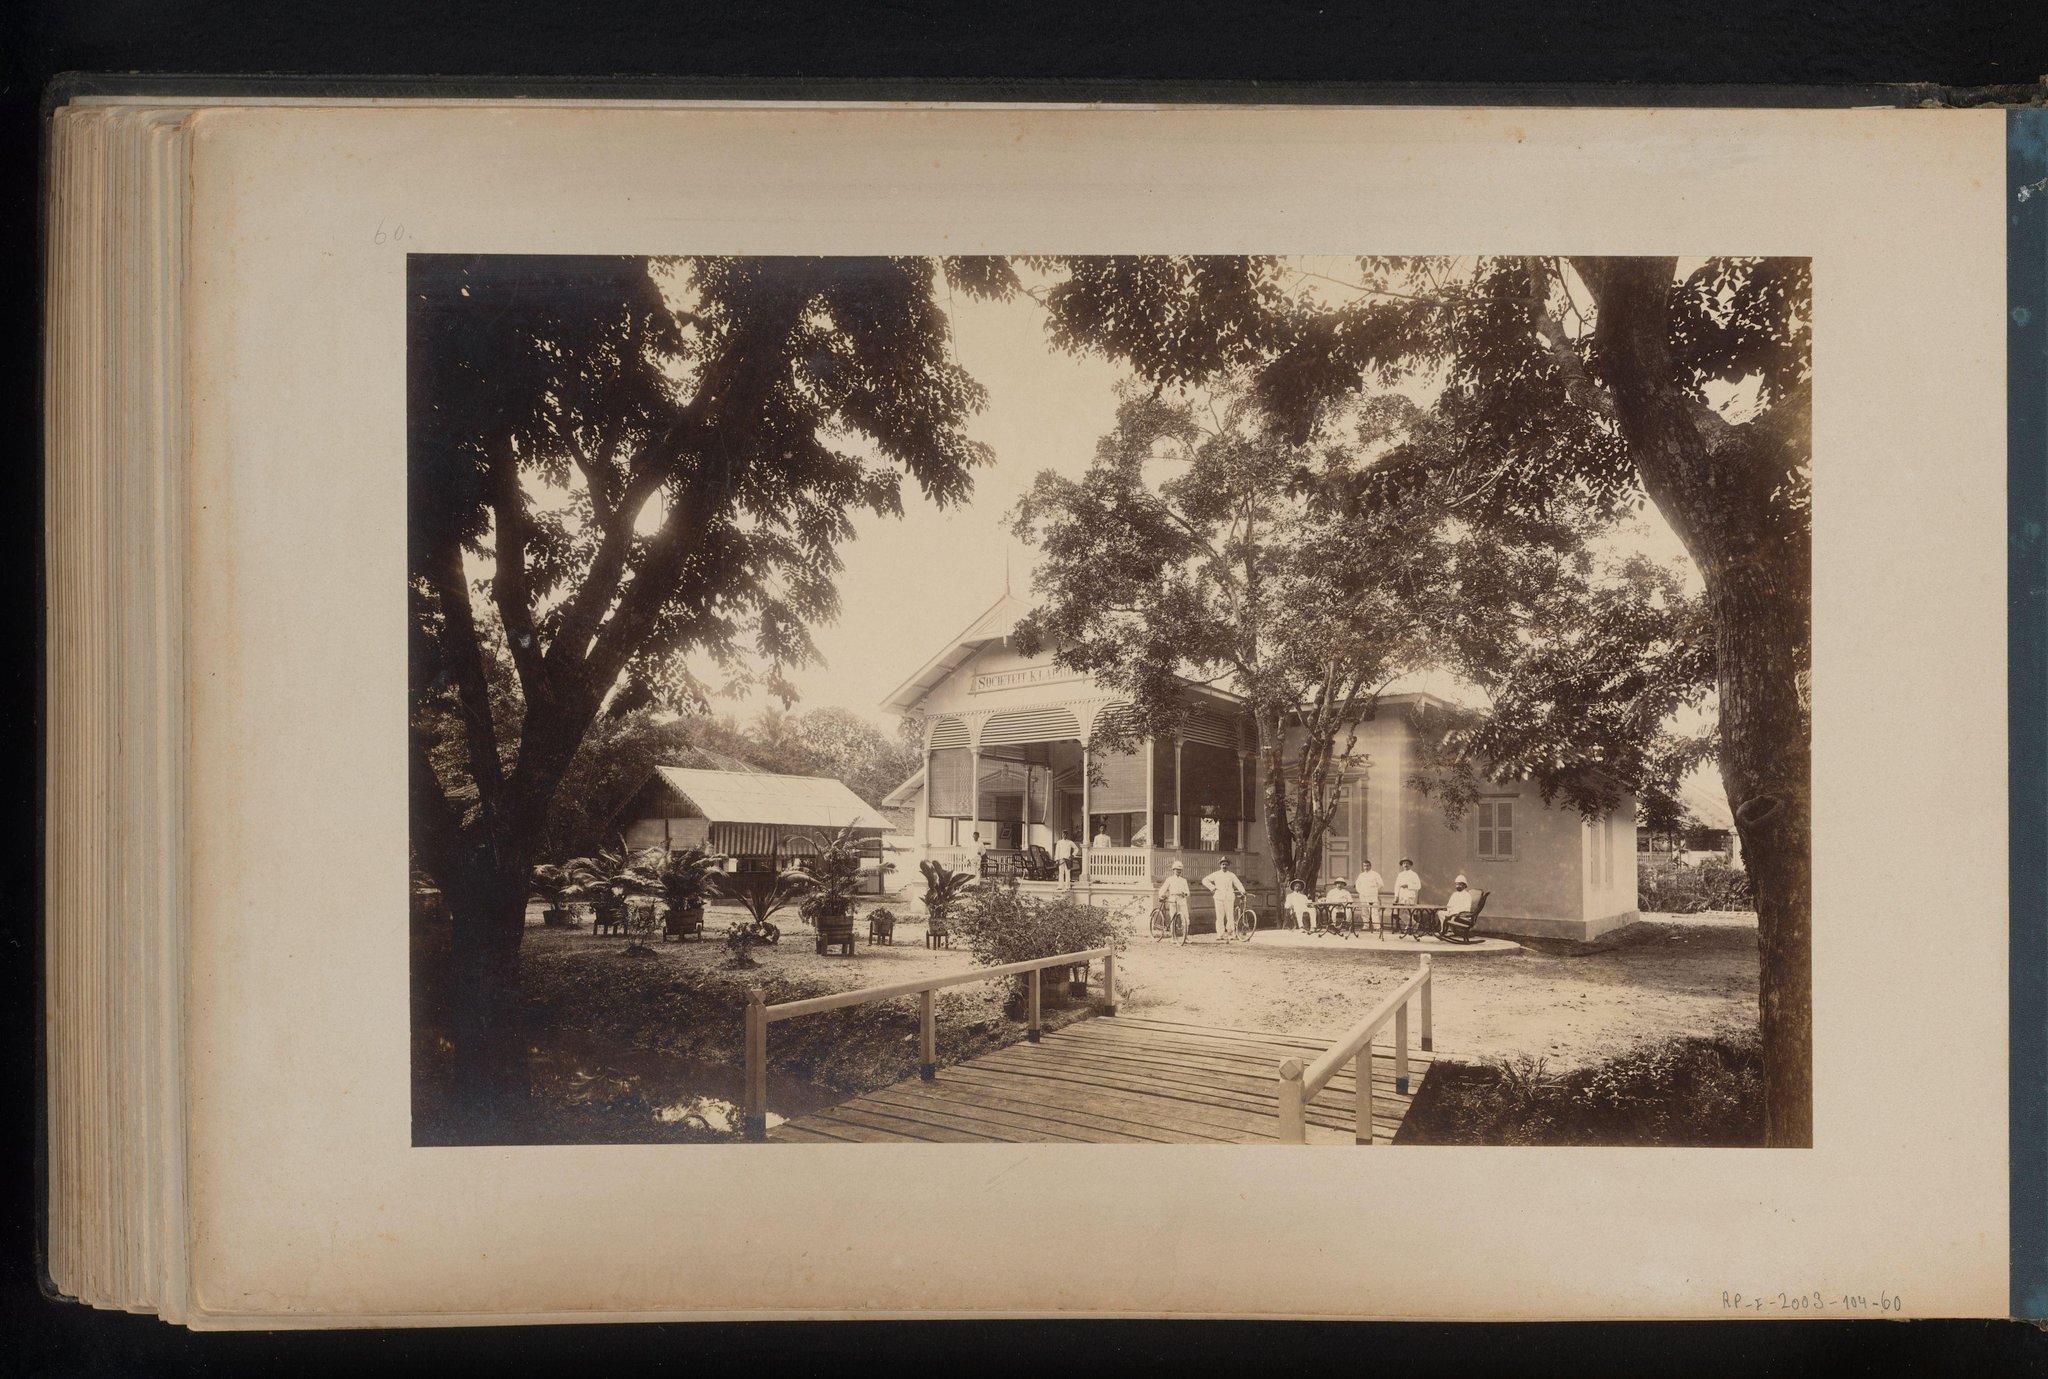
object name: album leaf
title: Gezicht op verenigingsgebouw Klambir in Tandjong Poera, Sumatra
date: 1890-1900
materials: cardboard, photographic support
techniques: albumen print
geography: tandjong poera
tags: societies and directory boards, villa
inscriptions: number: ‘60.’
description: In de lijst van afbeeldingen wordt deze foto beschreven met de woorden "Societät-Klambir, Tandjong Poera".